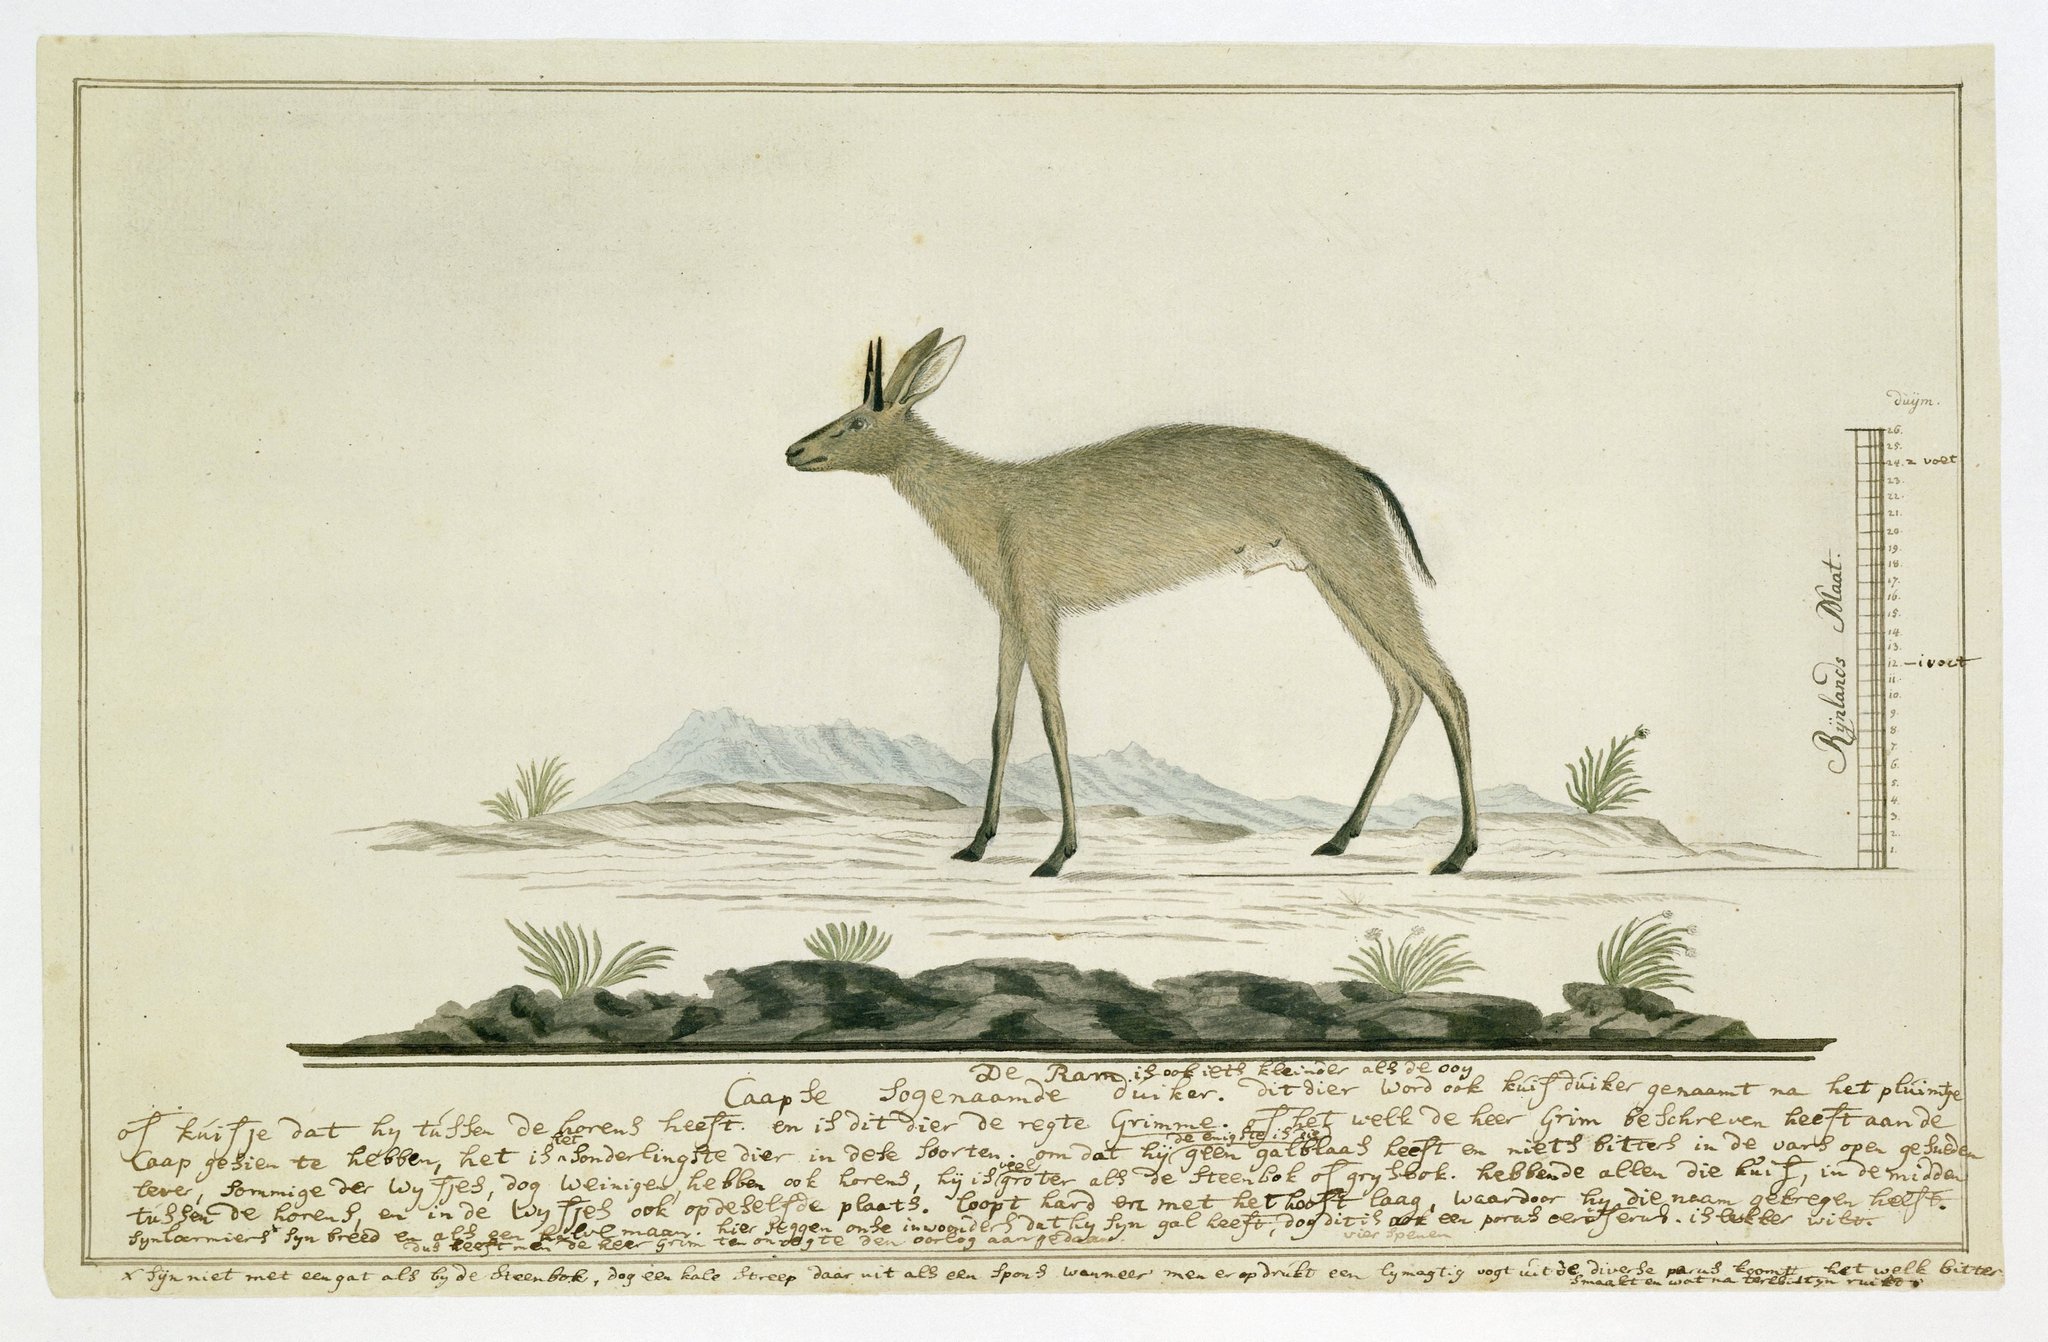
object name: drawing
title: Sylvicapra grimmia (Common Duiker)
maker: robert jacob gordon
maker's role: draughtsman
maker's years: 1743-1795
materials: paint, ink, paper, pencil, watercolor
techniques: brush, pen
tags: animals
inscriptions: annotation: ‘"De Ram.../ Caapse Sogenaamde duiker [...]; schaalverdeling rechts met Rijnlands Maat. ...voet en ...duijm’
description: De Kaapse duiker (Sylvicapra grimmia), ook genaamd kuifduiker: de ram.